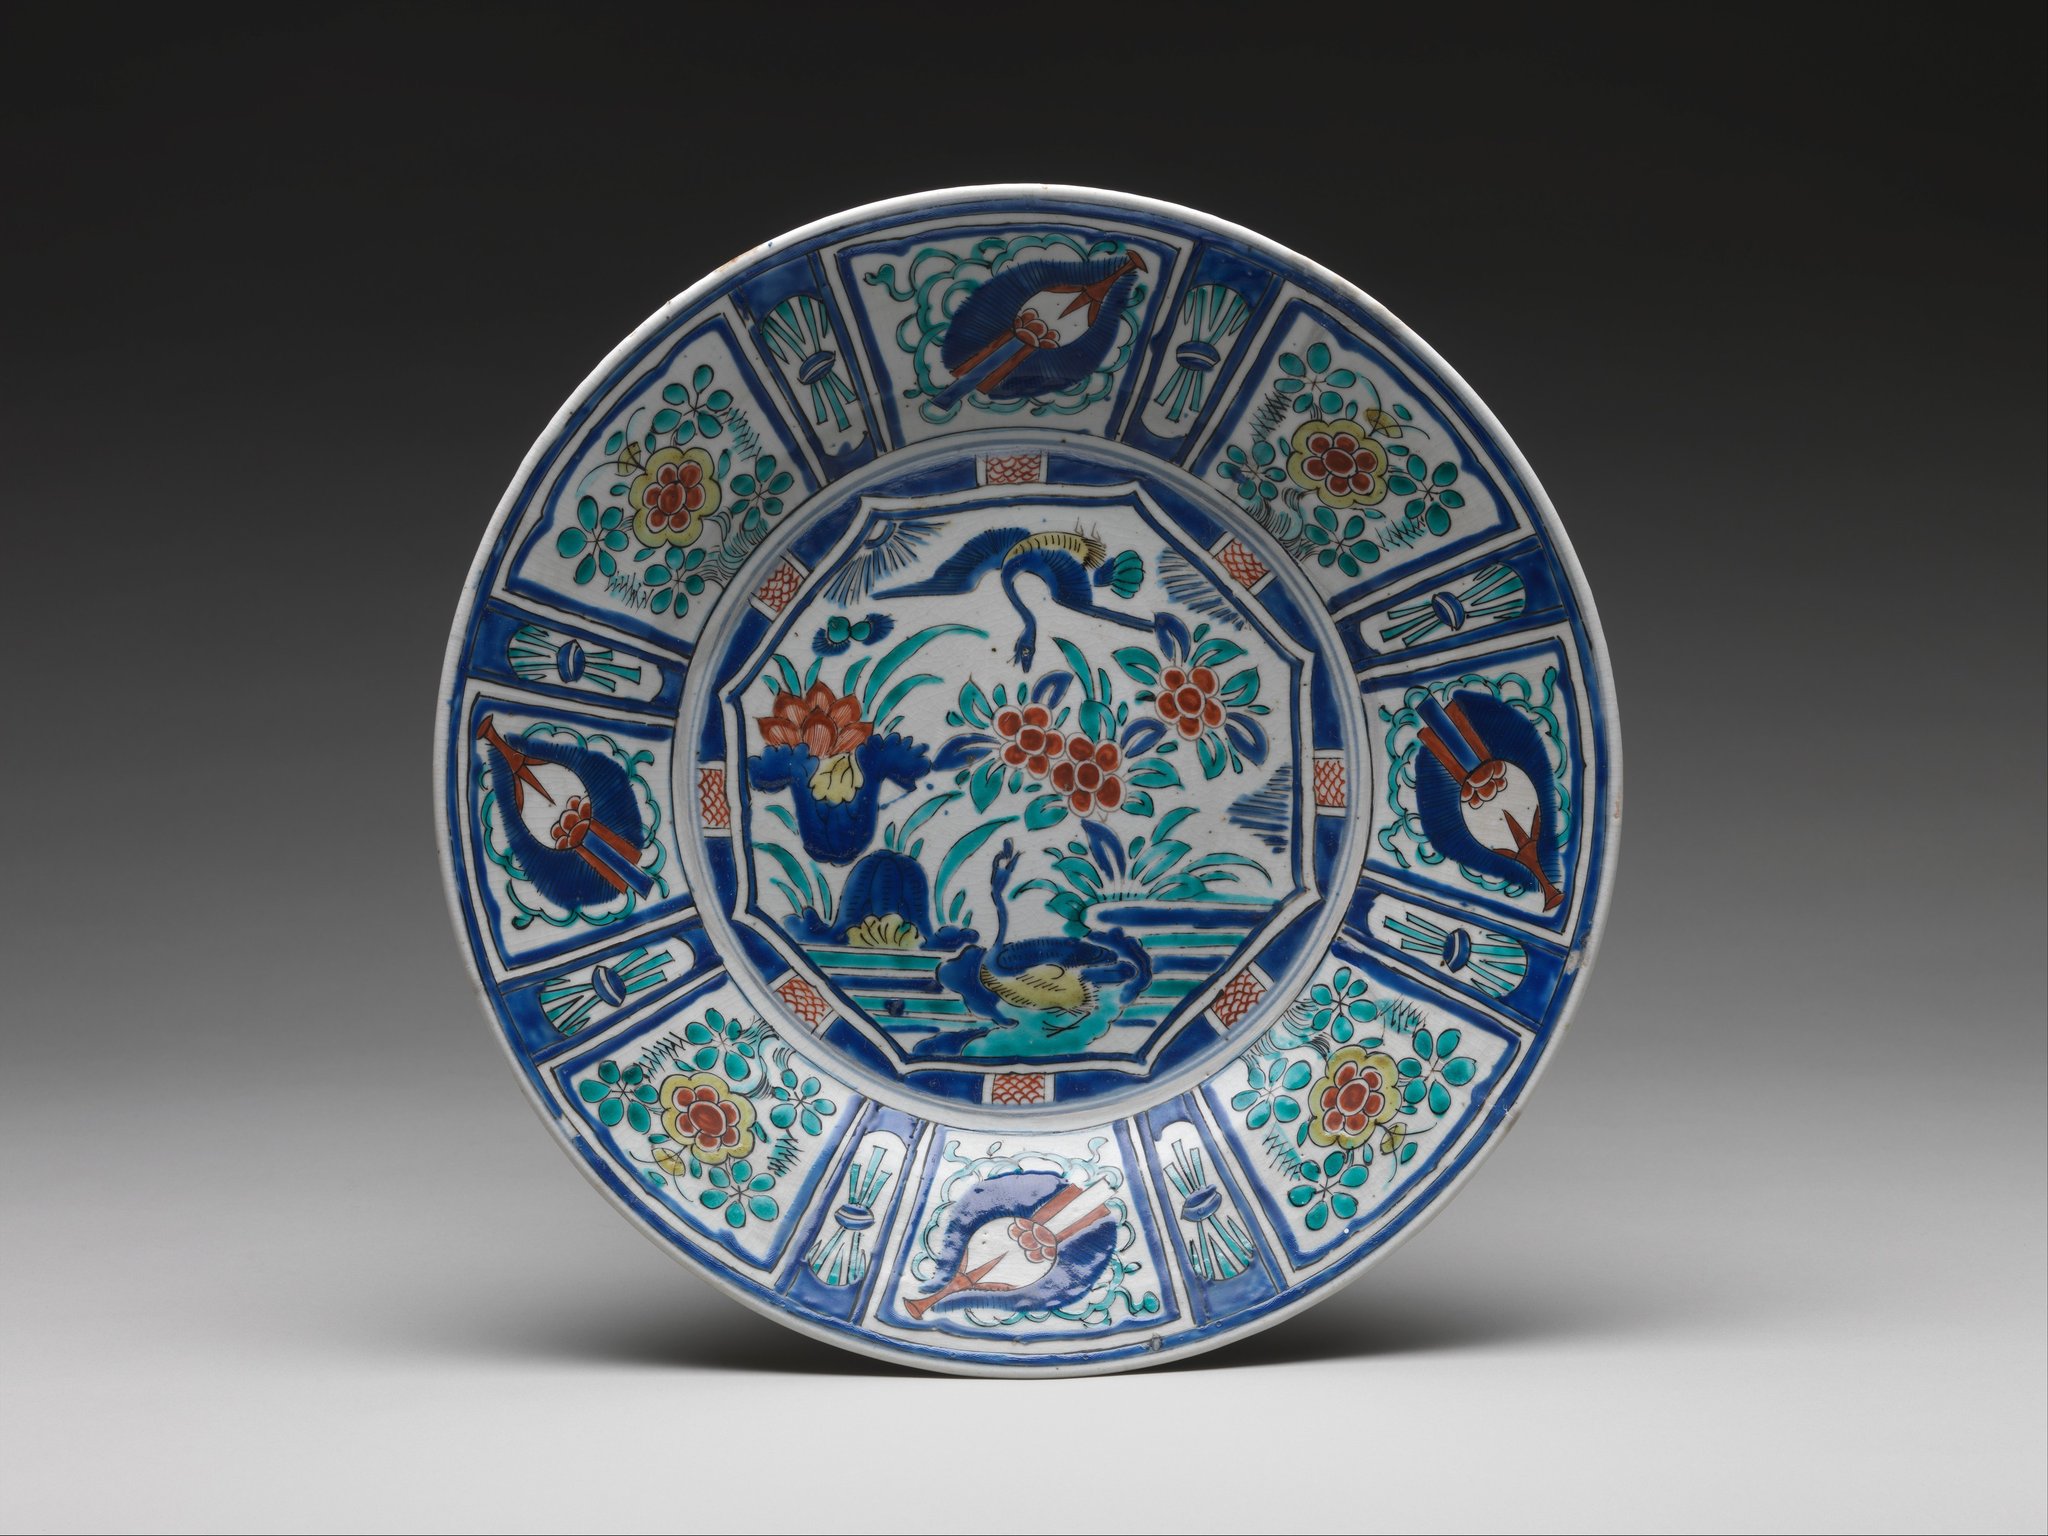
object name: dish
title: Plate with Geese in Lotus Pond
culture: japanese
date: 1660-1680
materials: enamel, glaze, porcelain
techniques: painting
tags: birds,flowers